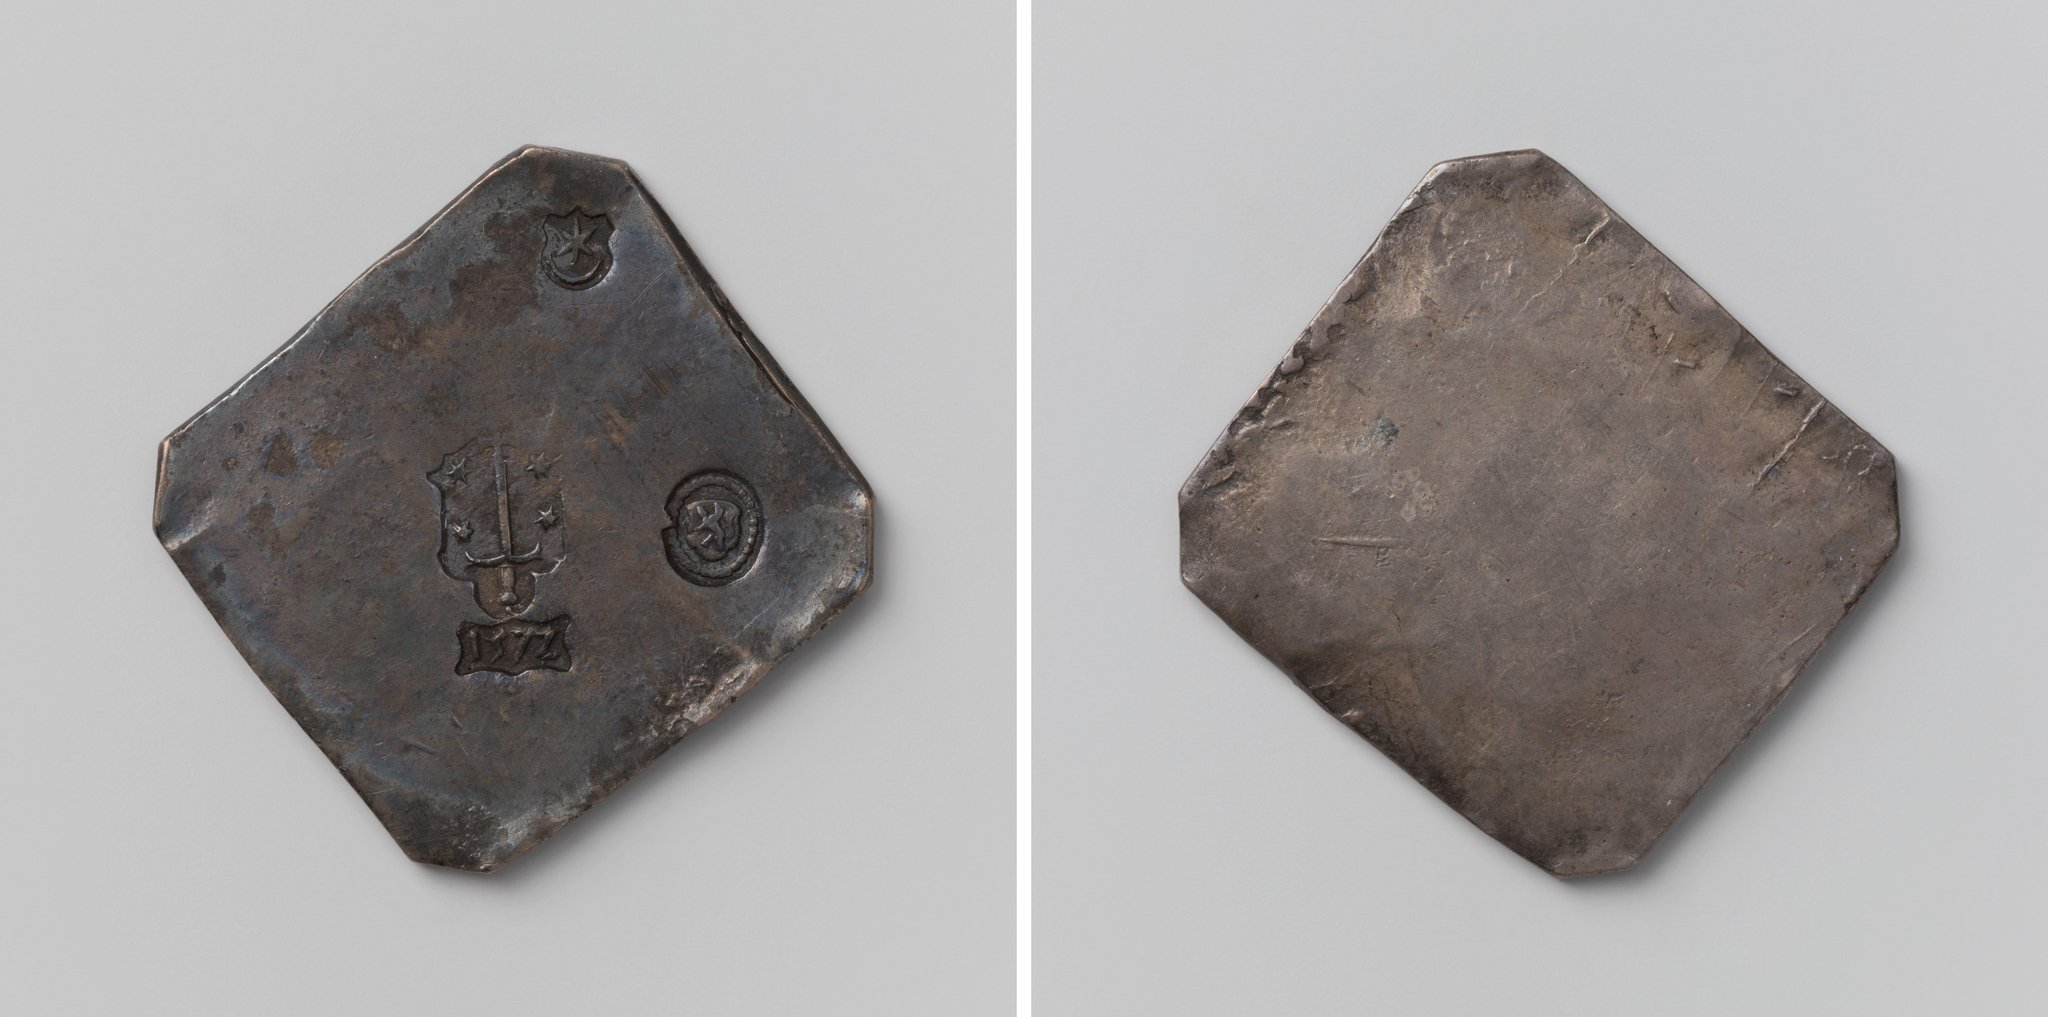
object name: coin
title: Daalder, noodmunt uit Haarlem, geslagen tijdens het beleg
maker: Anonymous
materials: silver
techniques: striking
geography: haarlem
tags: haarlem